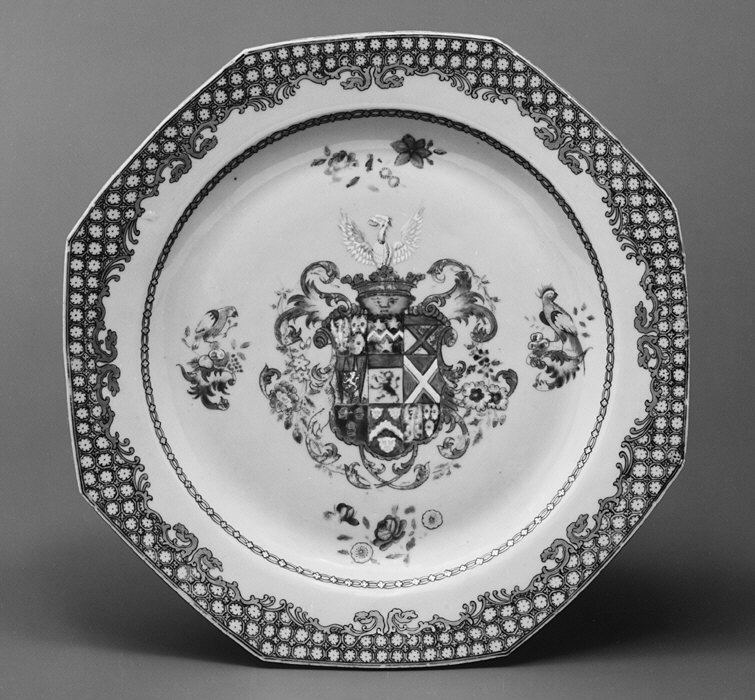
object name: plate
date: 1745-1755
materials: hard paste porcelain